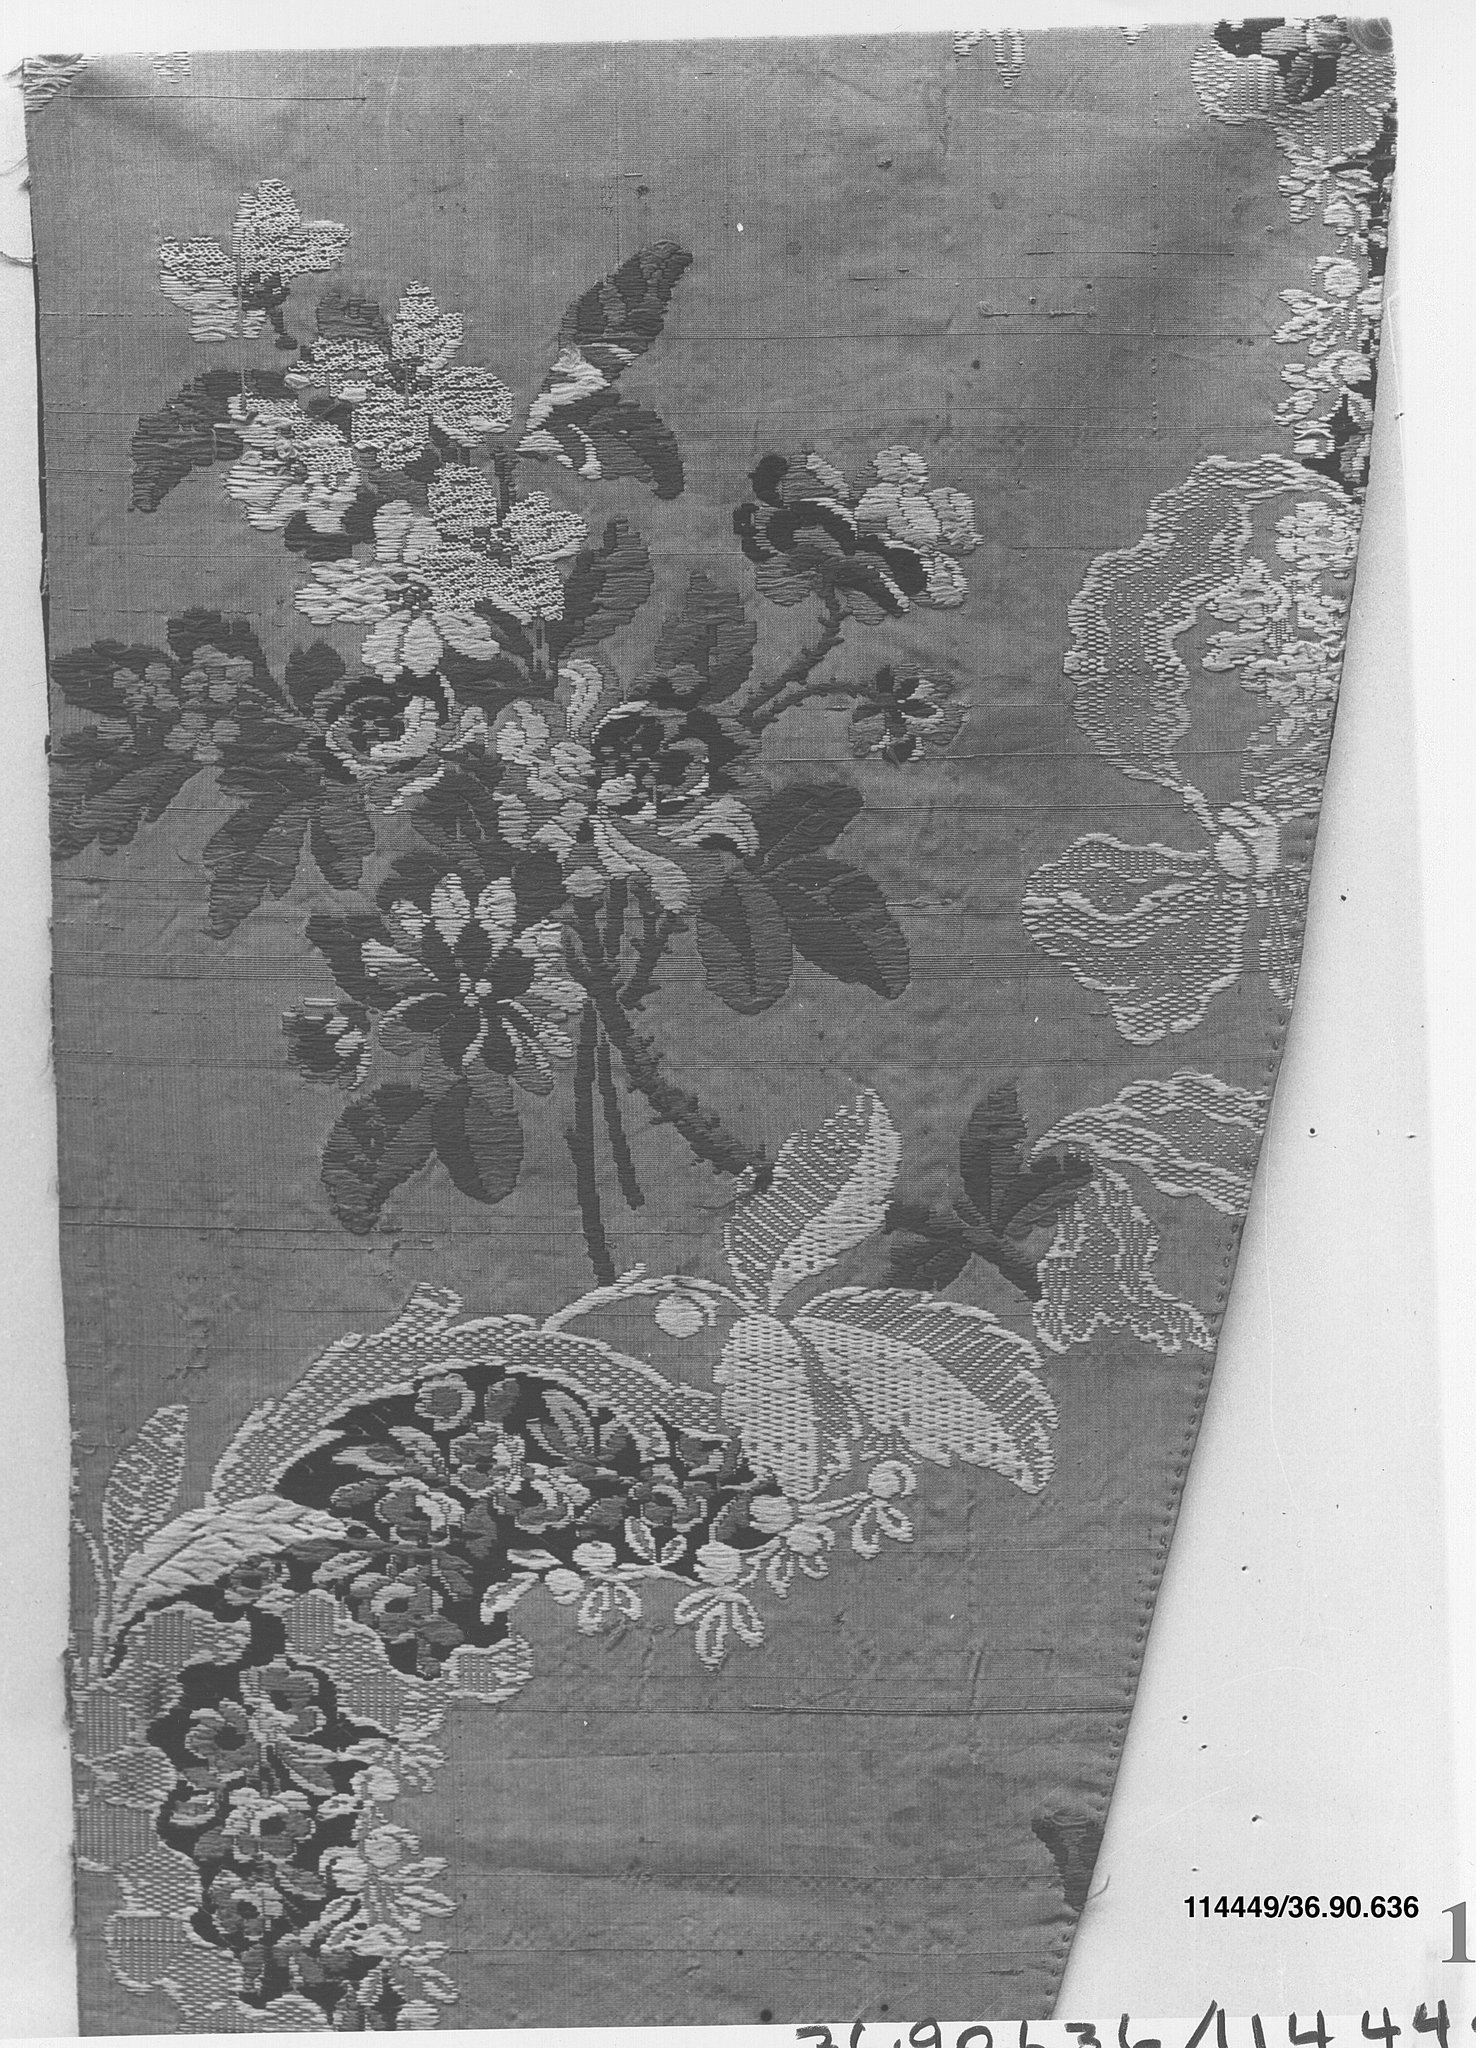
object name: piece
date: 1750-1760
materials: silk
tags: flowers,leaves